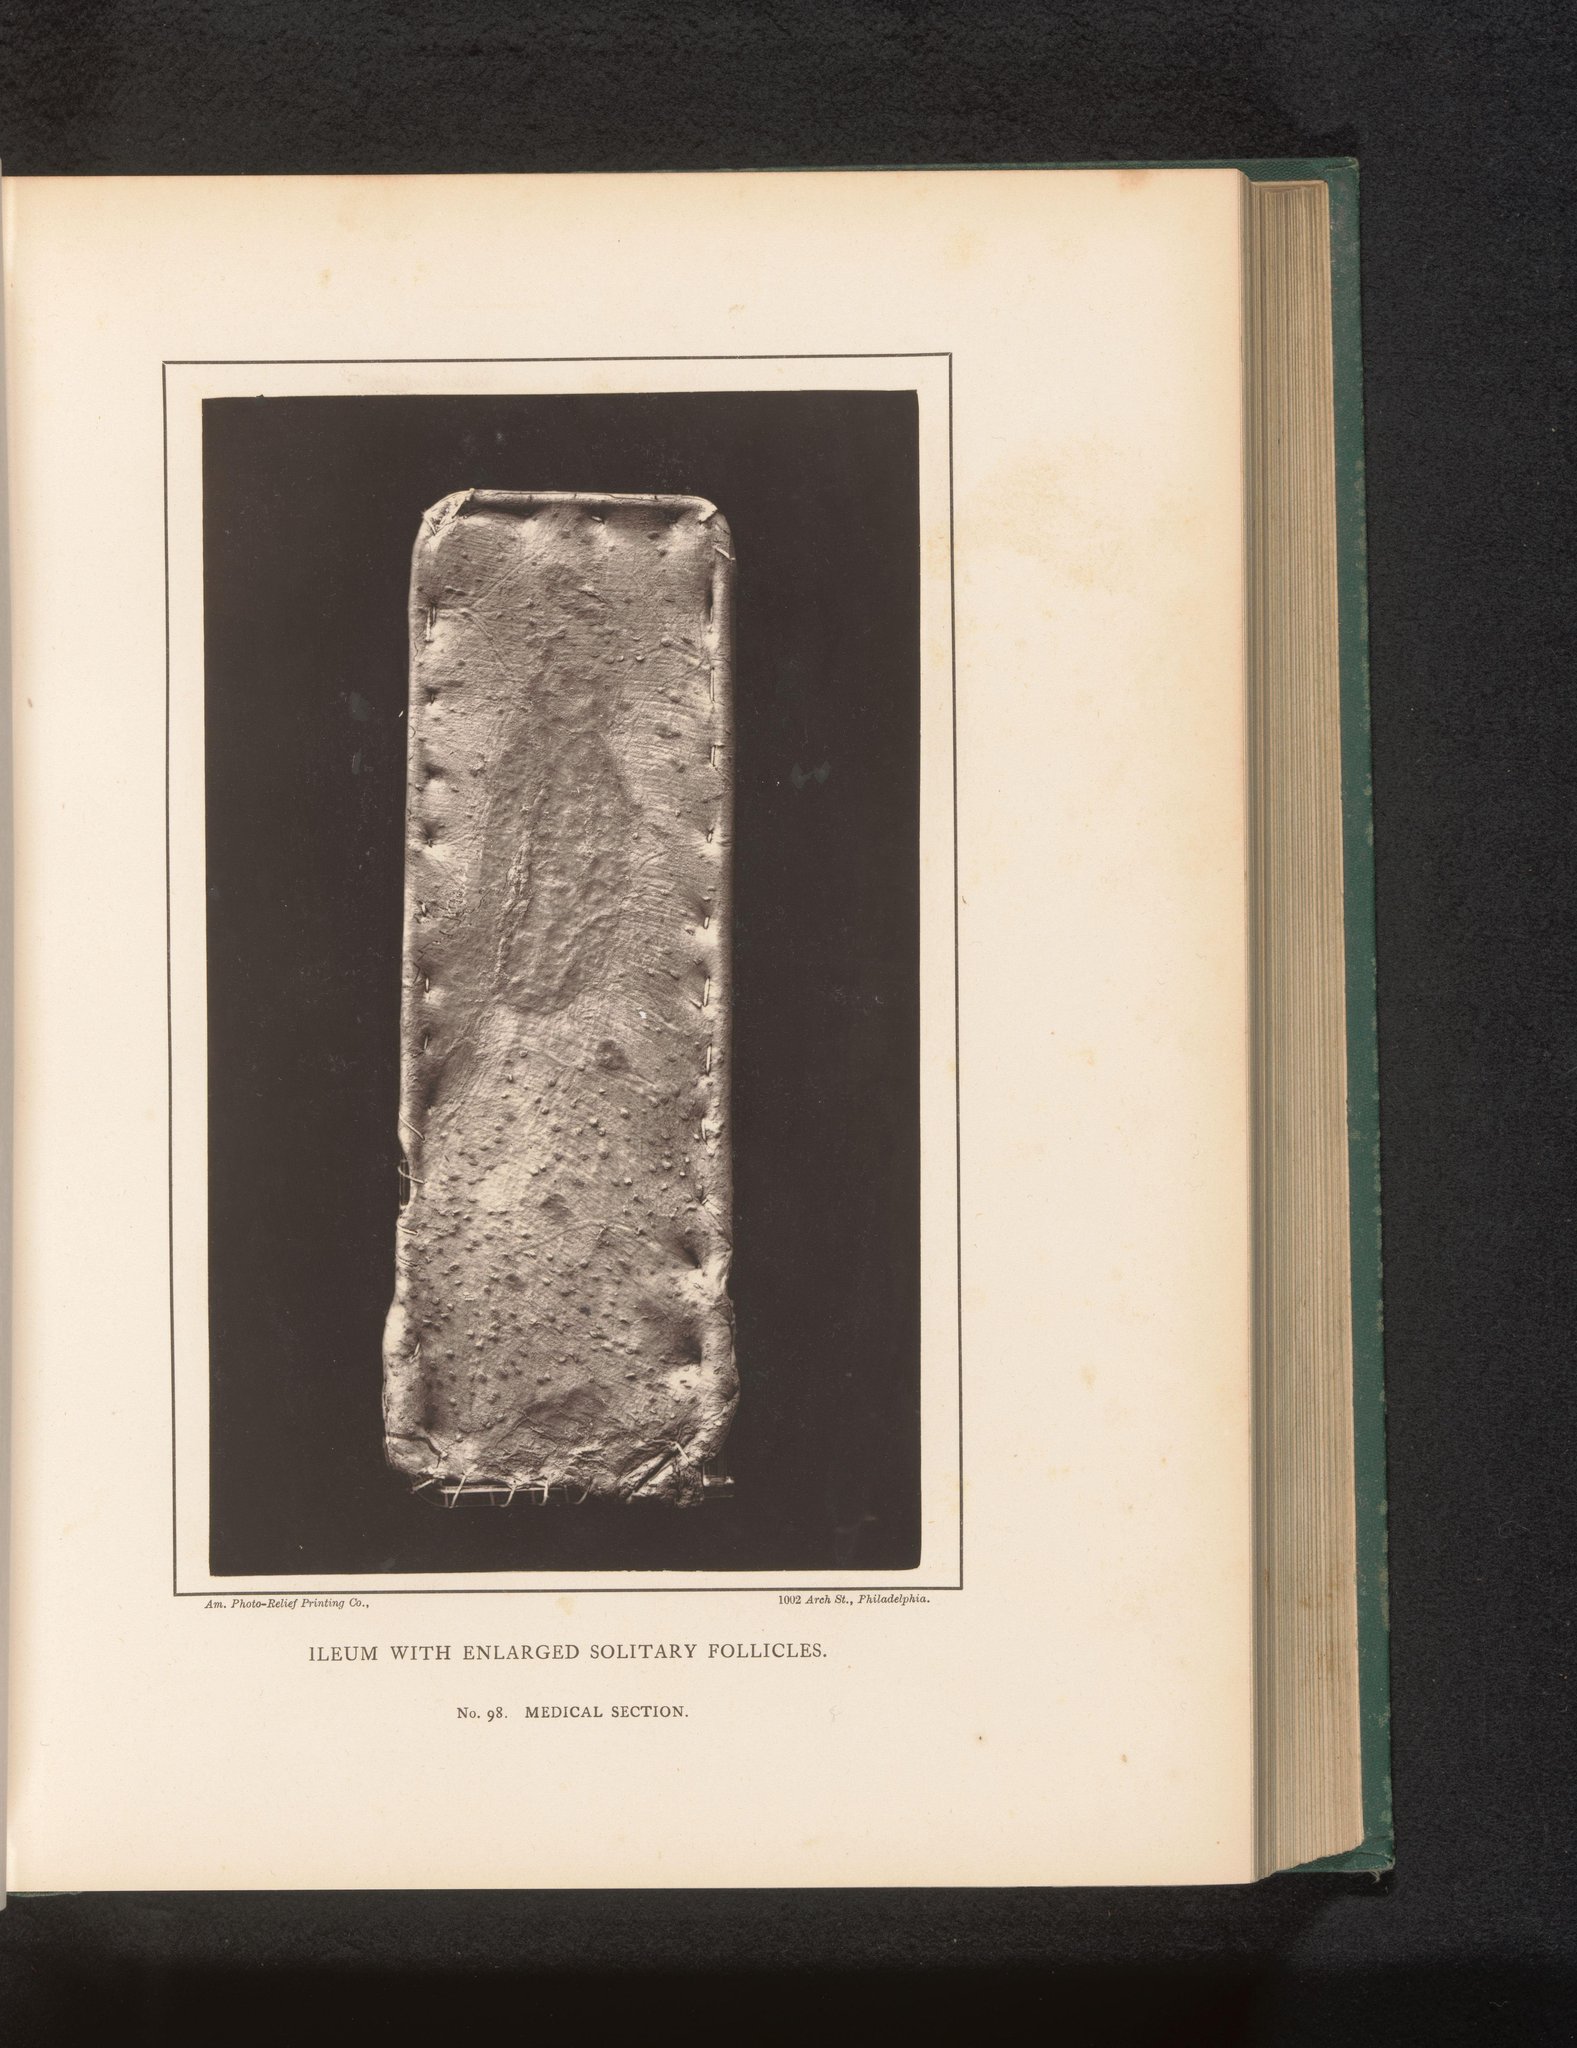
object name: page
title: Ileum with Enlarged Solitary Follicles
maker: edward j. ward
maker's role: fotograaf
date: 1874-1879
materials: paper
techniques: woodburytype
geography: philadelphia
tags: intestines, anatomical specimen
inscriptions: number: ‘No. 98. MEDICAL SECTION.’, address: ‘1002 Arch St., Philadelphia.’